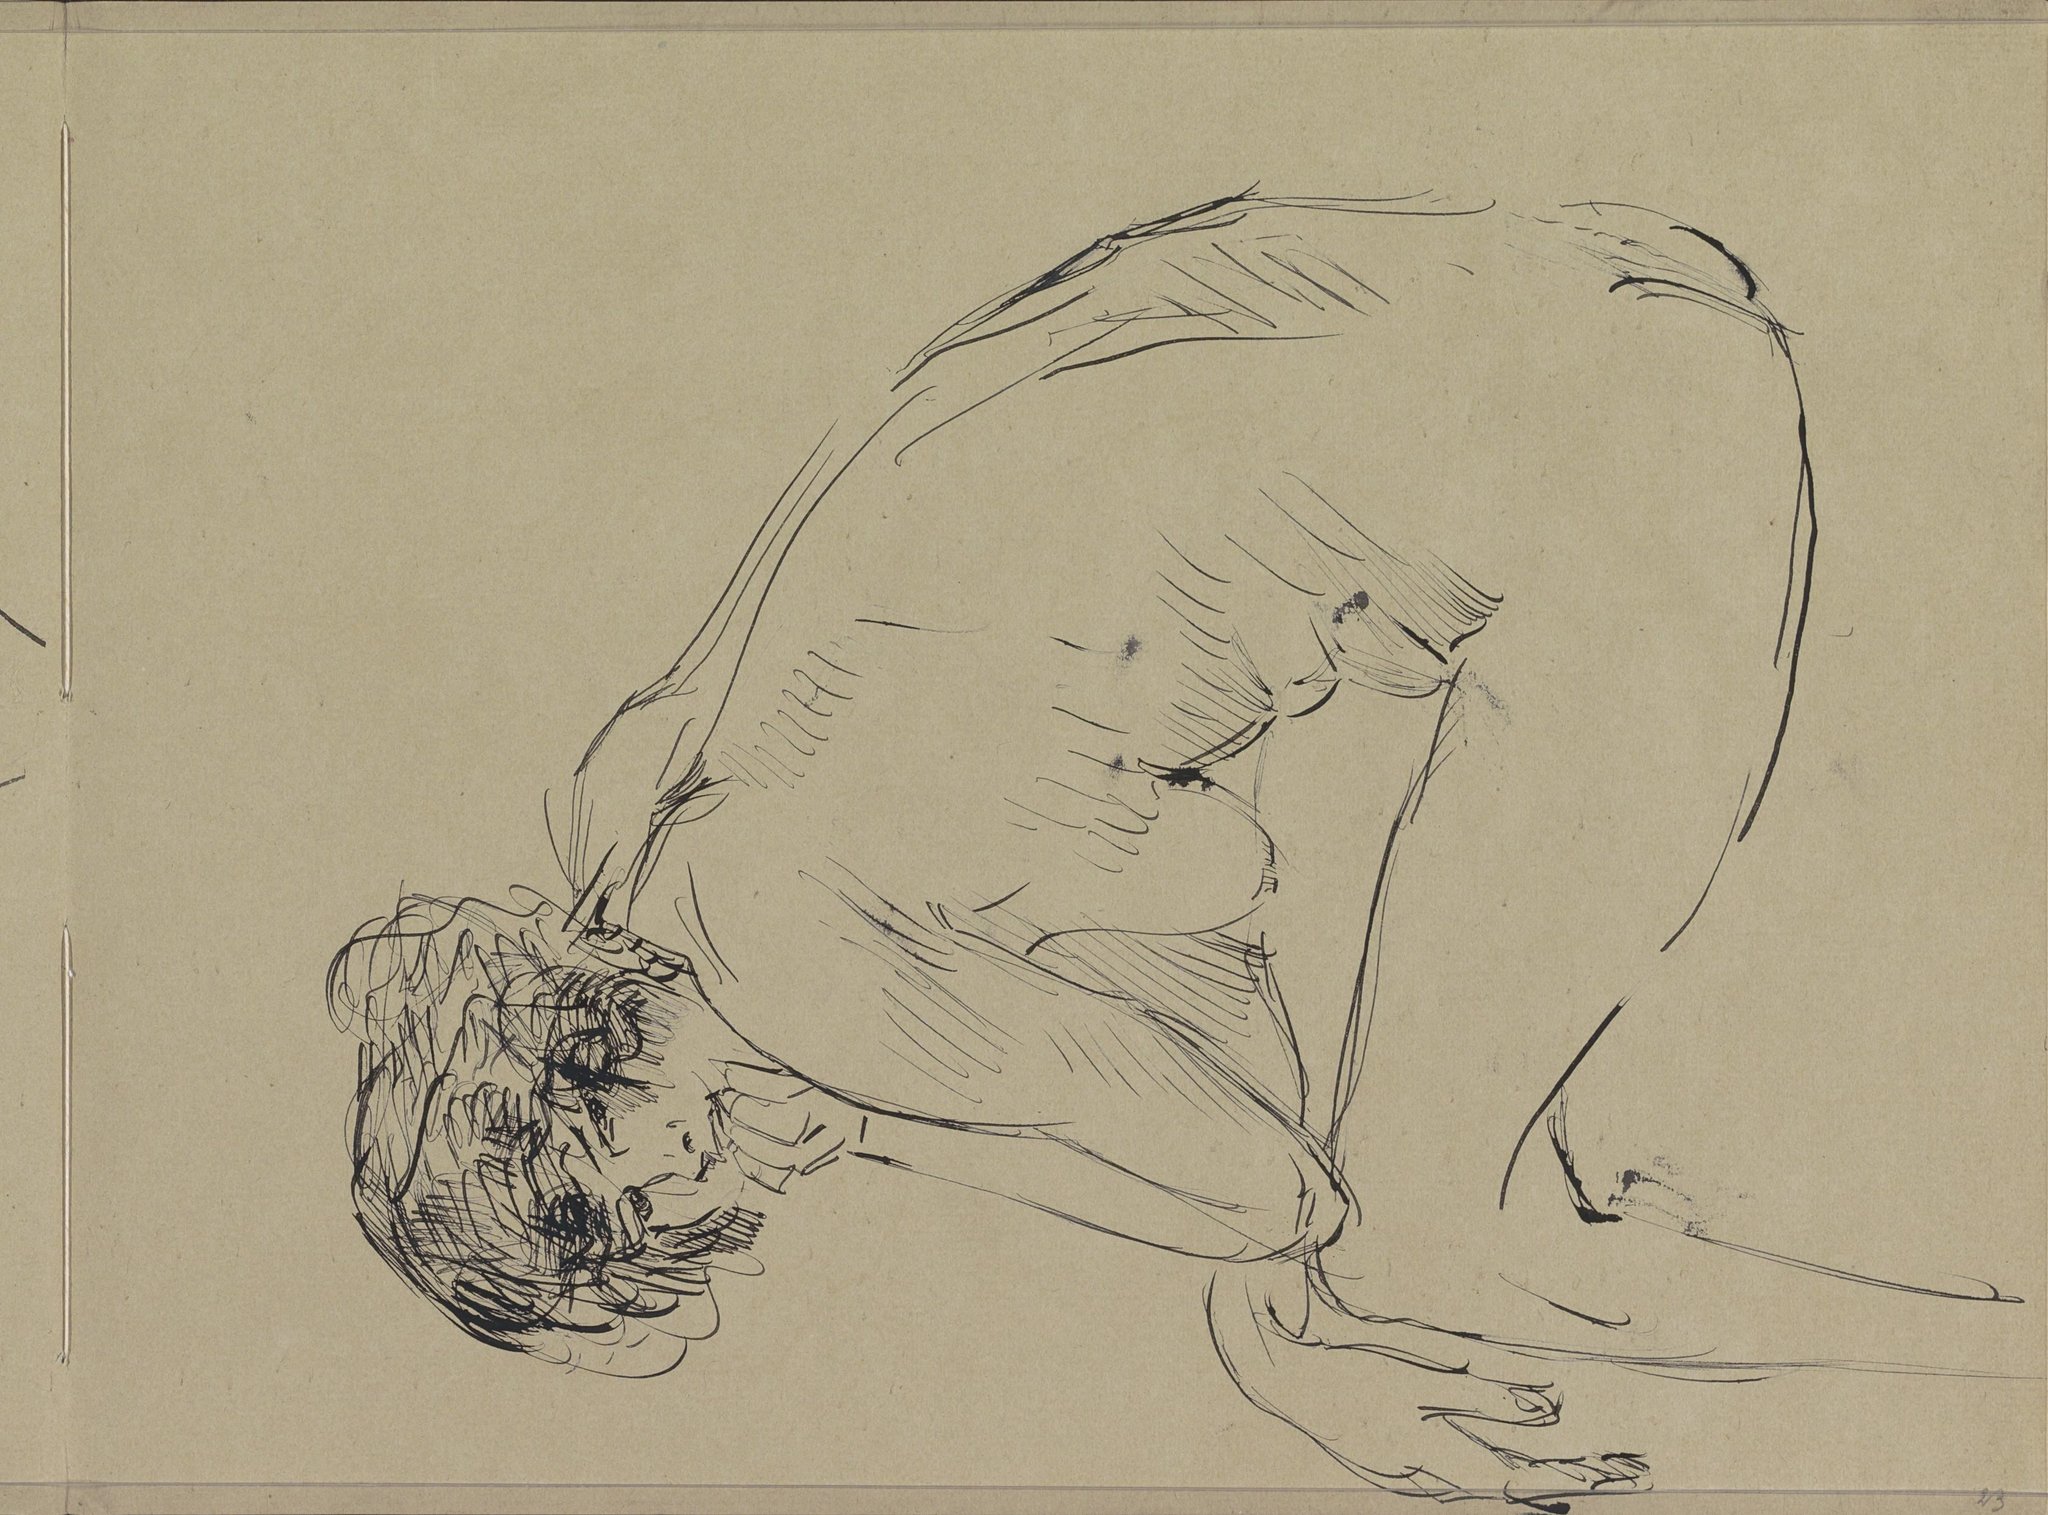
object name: sketchbook leaf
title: Zittend vrouwelijk naakt, voorovergebogen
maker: isaac israels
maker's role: draughtsman, painter, print maker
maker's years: 1865-1934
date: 1875-1934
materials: ink, paper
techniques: pen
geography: the hague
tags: sitting figure - aa - female human figure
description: Blad 23 recto uit schetsboek IV met 27 bladen.